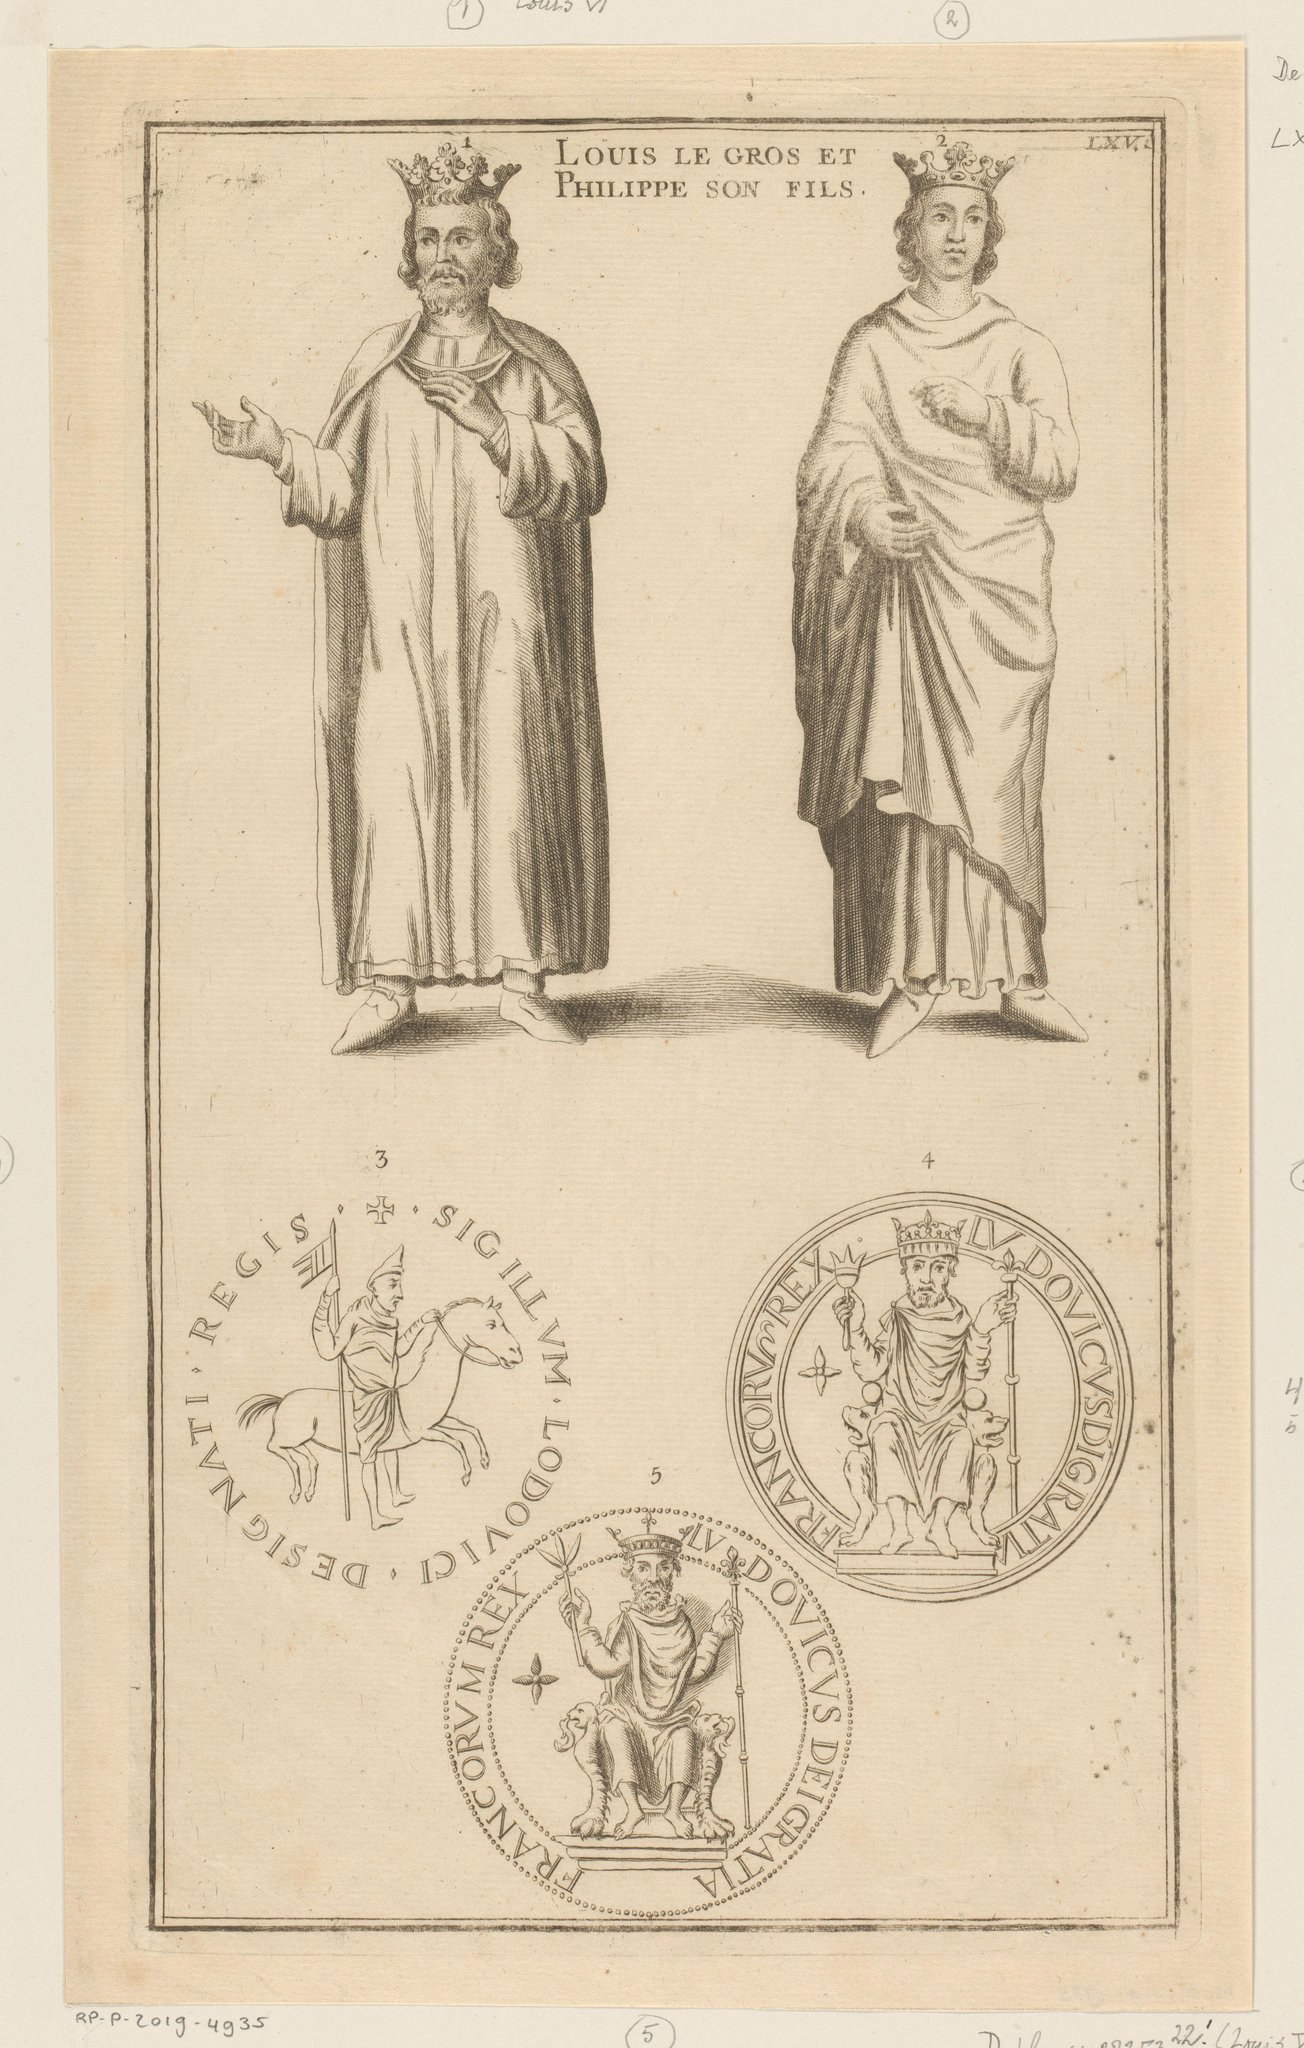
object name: book illustration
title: Afbeeldingen van koning Lodewijk VI en Lodewijk VII van Frankrijk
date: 1750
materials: paper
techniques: engraving, etching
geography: london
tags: paris, historical persons, piece of sculpture, reproduction of a piece of sculpture, king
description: Prent uit: Montfaucon, Bernard de. A collection of regal and ecclesiastical antiquities of France (...). Londen: William Innys, John en Paul Knapton, R. Manby en Henry Shute Cox, 1750, dl. 1. Prent voor het eerst, met andere nummering, verschenen in: Montfaucon, Bernard de. Les monumens de la Monarchie Françoise (...). Parijs: Julien-Michel Gandouin en Pierre-François Giffart, 1729-1733.